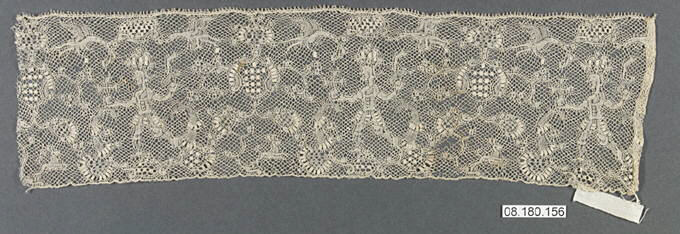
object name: strip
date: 1701-1733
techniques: lace